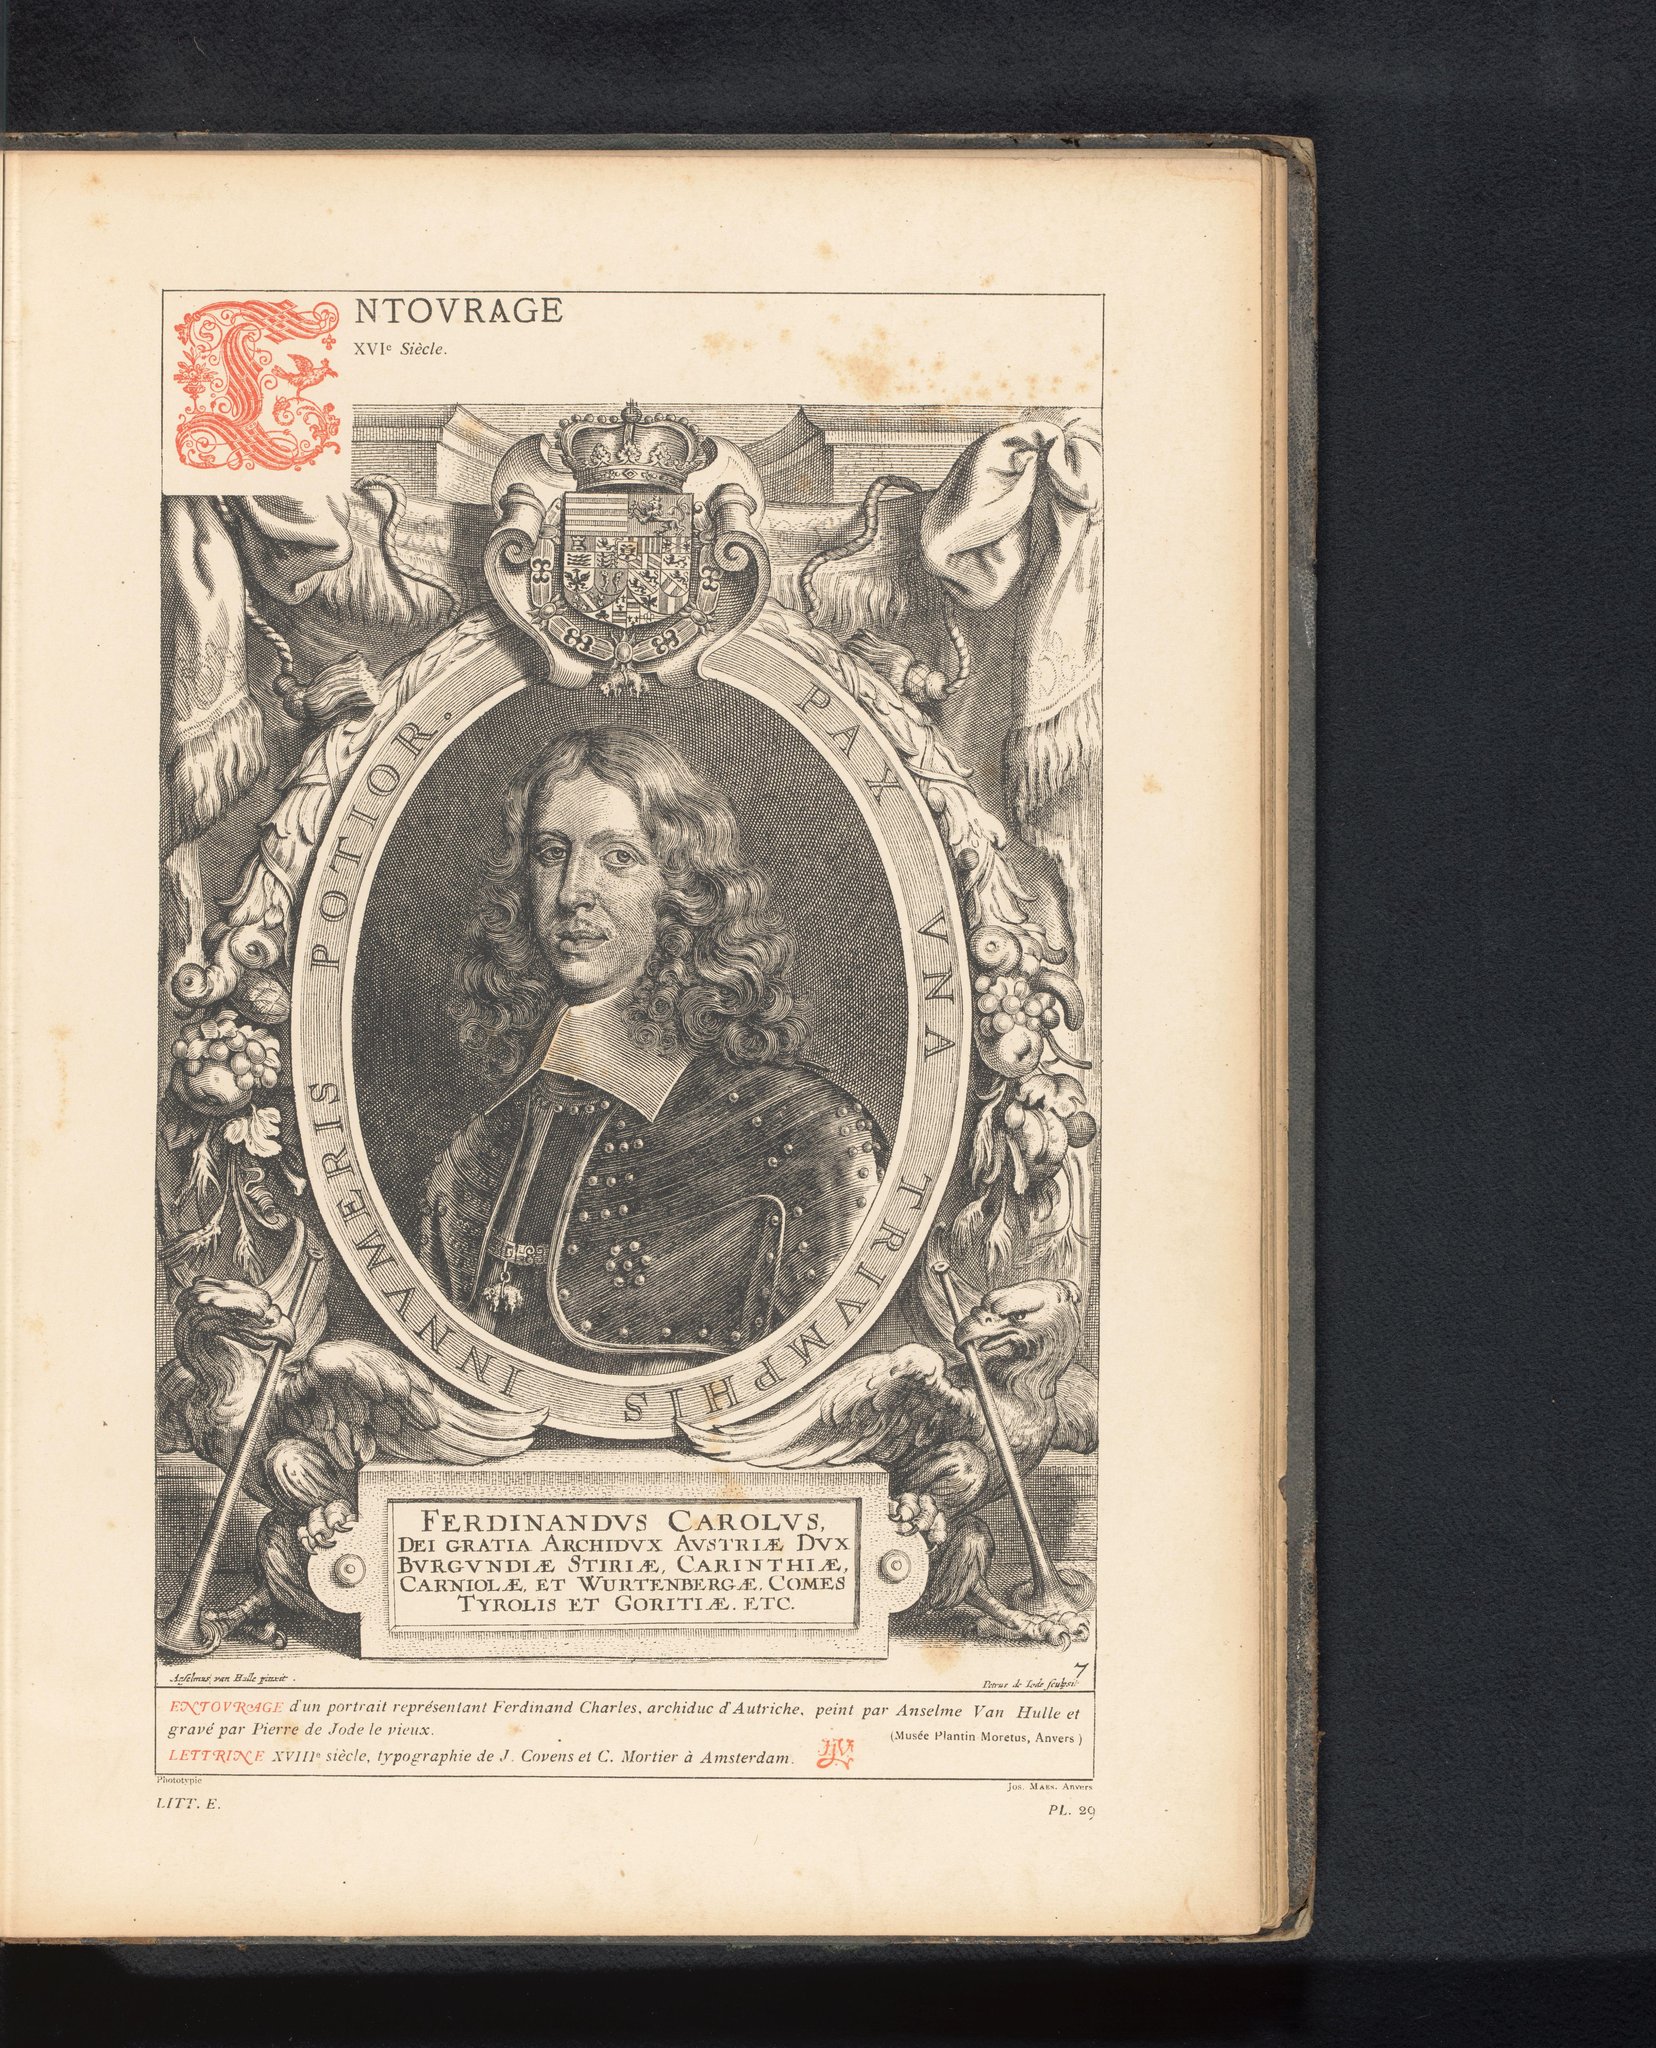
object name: page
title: Entourage, XVIe Siècle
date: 1875-1880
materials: paper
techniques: photolithography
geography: amsterdam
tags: ferdinand iii (duits keizer), historical persons, emperor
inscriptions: inscription: ‘LITT. E. - PL. 29’, monogram: ‘JJvY’, inscription: ‘ENTOURAGE d'un portrait (...)’